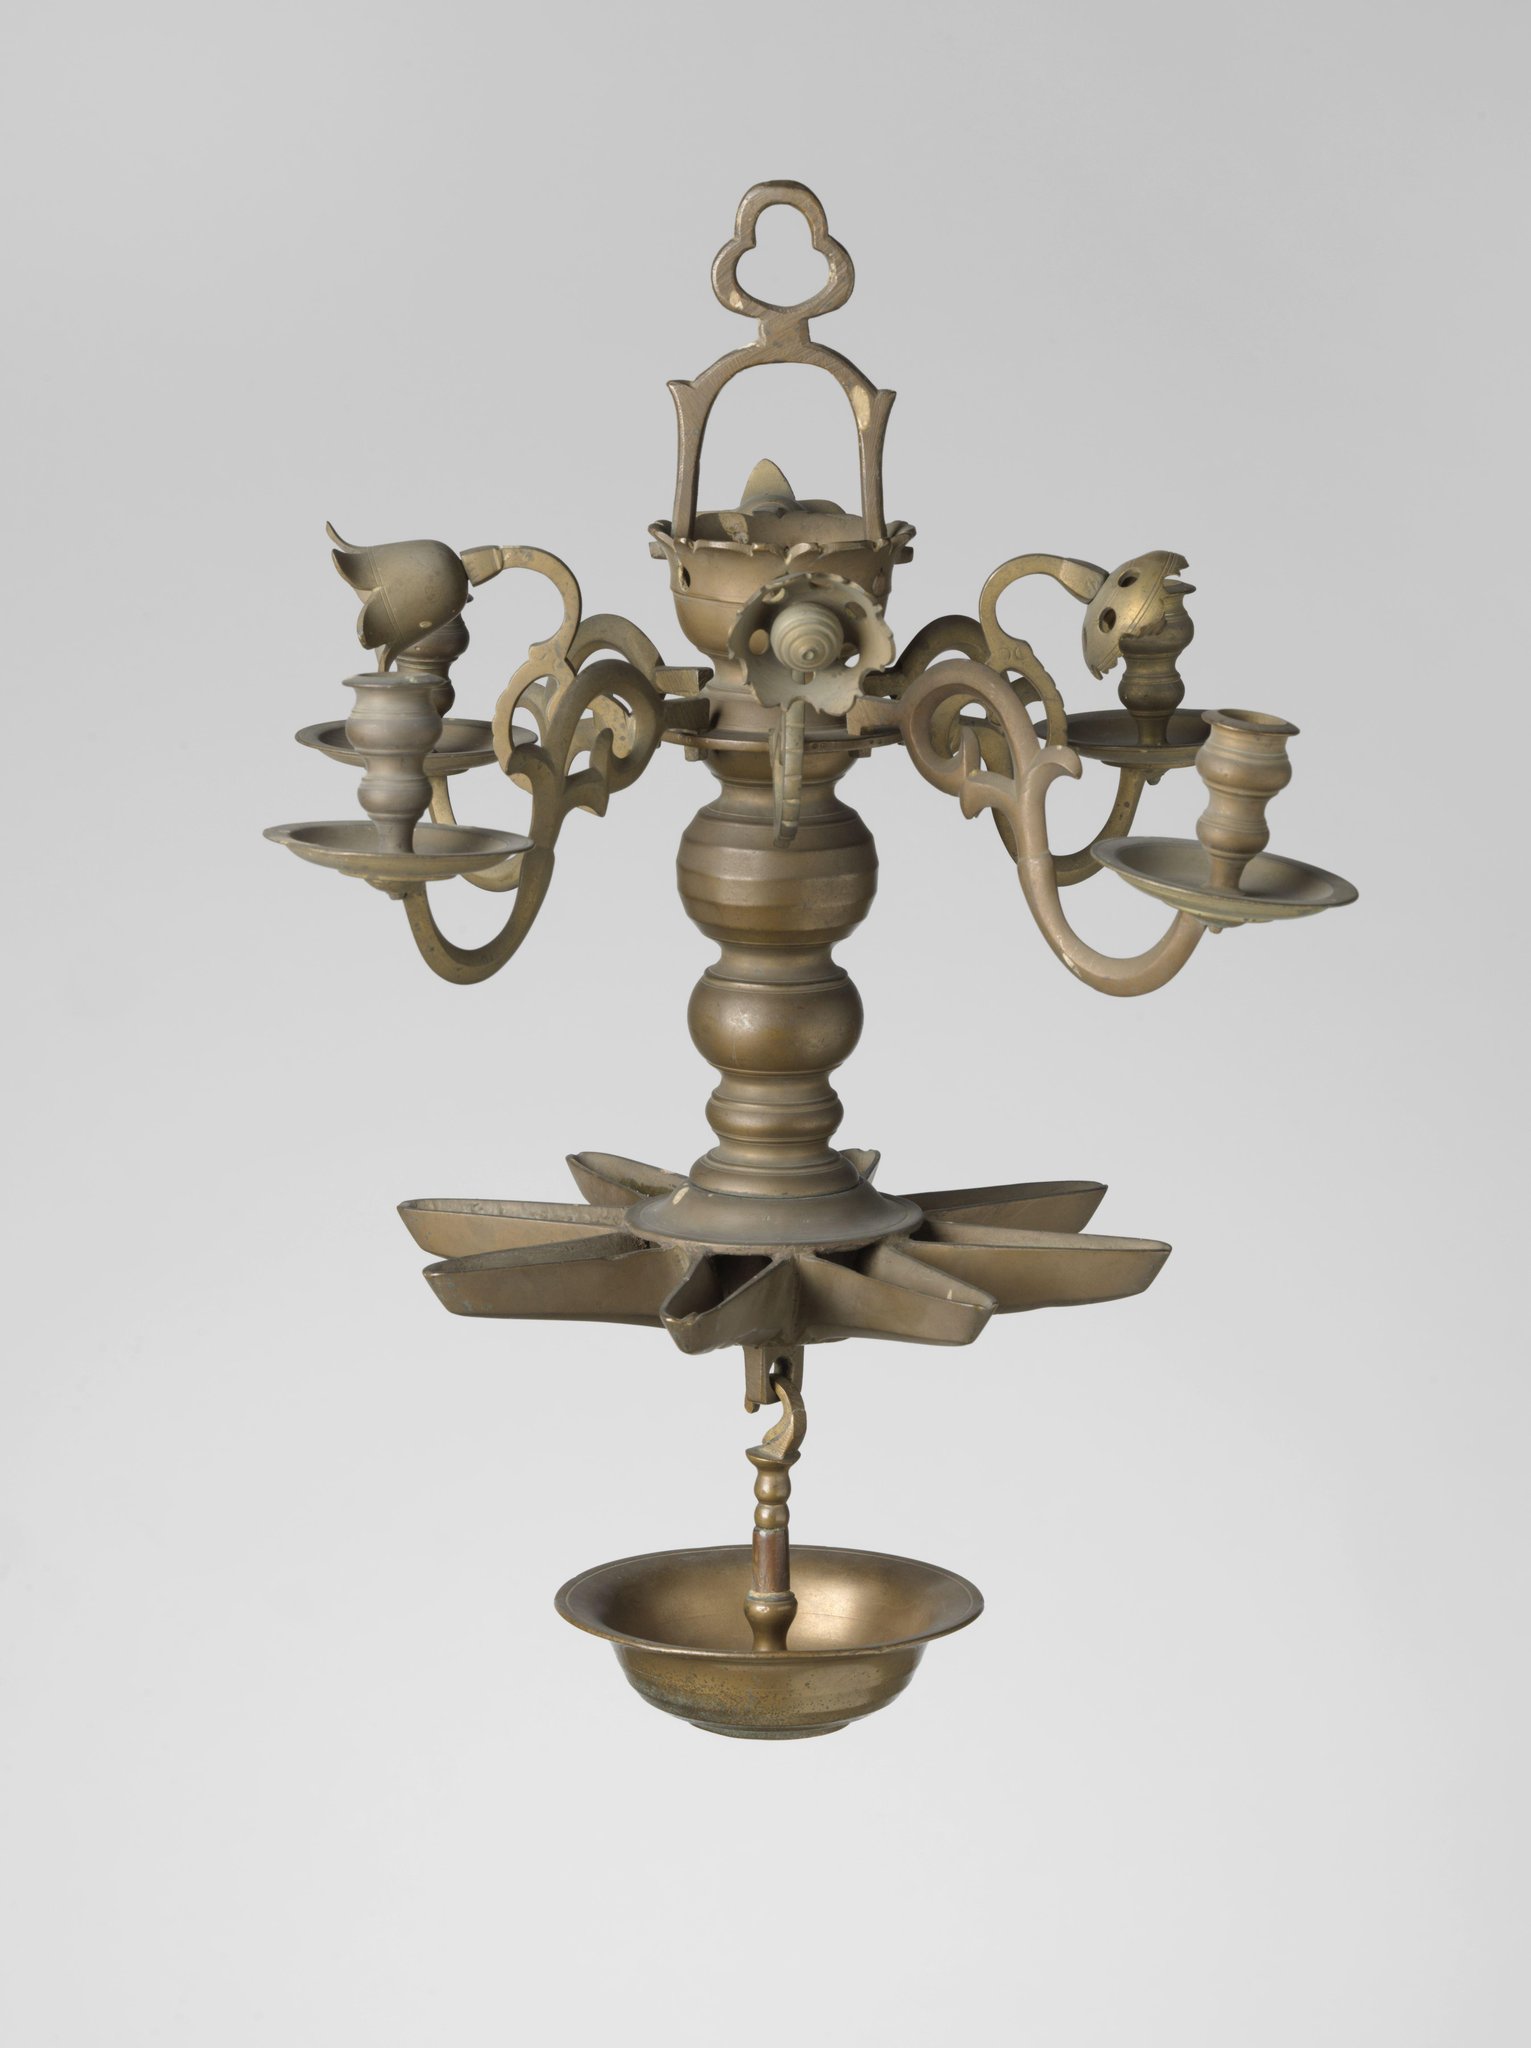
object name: sabbath lamp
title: Arm van sabbathlamp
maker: Anonymous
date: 1700-1800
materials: brass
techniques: casting, screwed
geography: nuremberg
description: Arm van een sabbathlamp. De S-vormige arm eindigt naar de stam toe in een krul en gaat naar buiten toe over in een plat bevestigingsdeel, waarin de bol- en holronde zich naar de voet verjongende houder op de geprofileerde ronde vetvanger is geschroefd. Dit is de eerste arm, genummerd met 1 ronde punt.